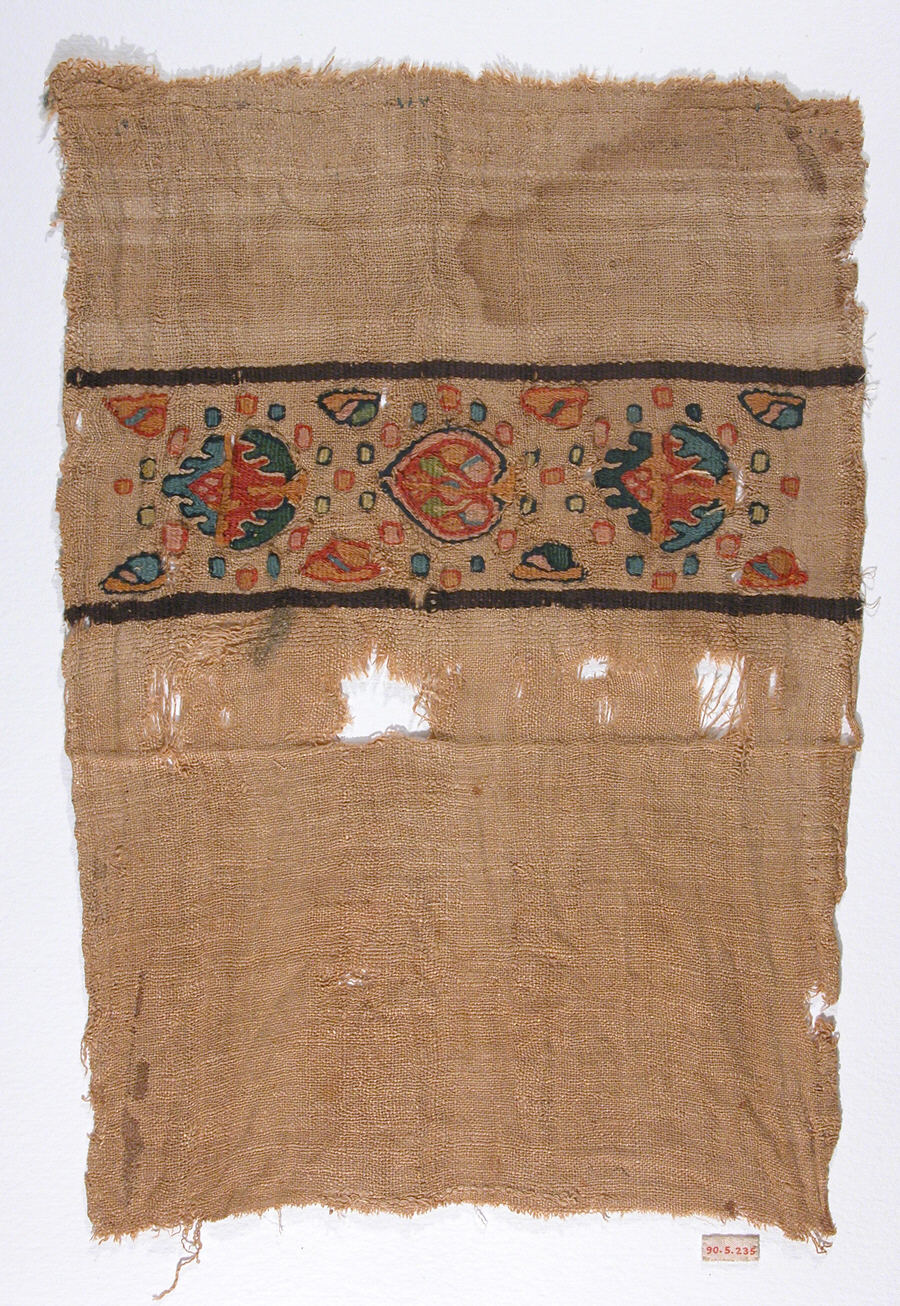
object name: textile fragment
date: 401-600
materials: linen, wool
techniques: weave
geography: egypt